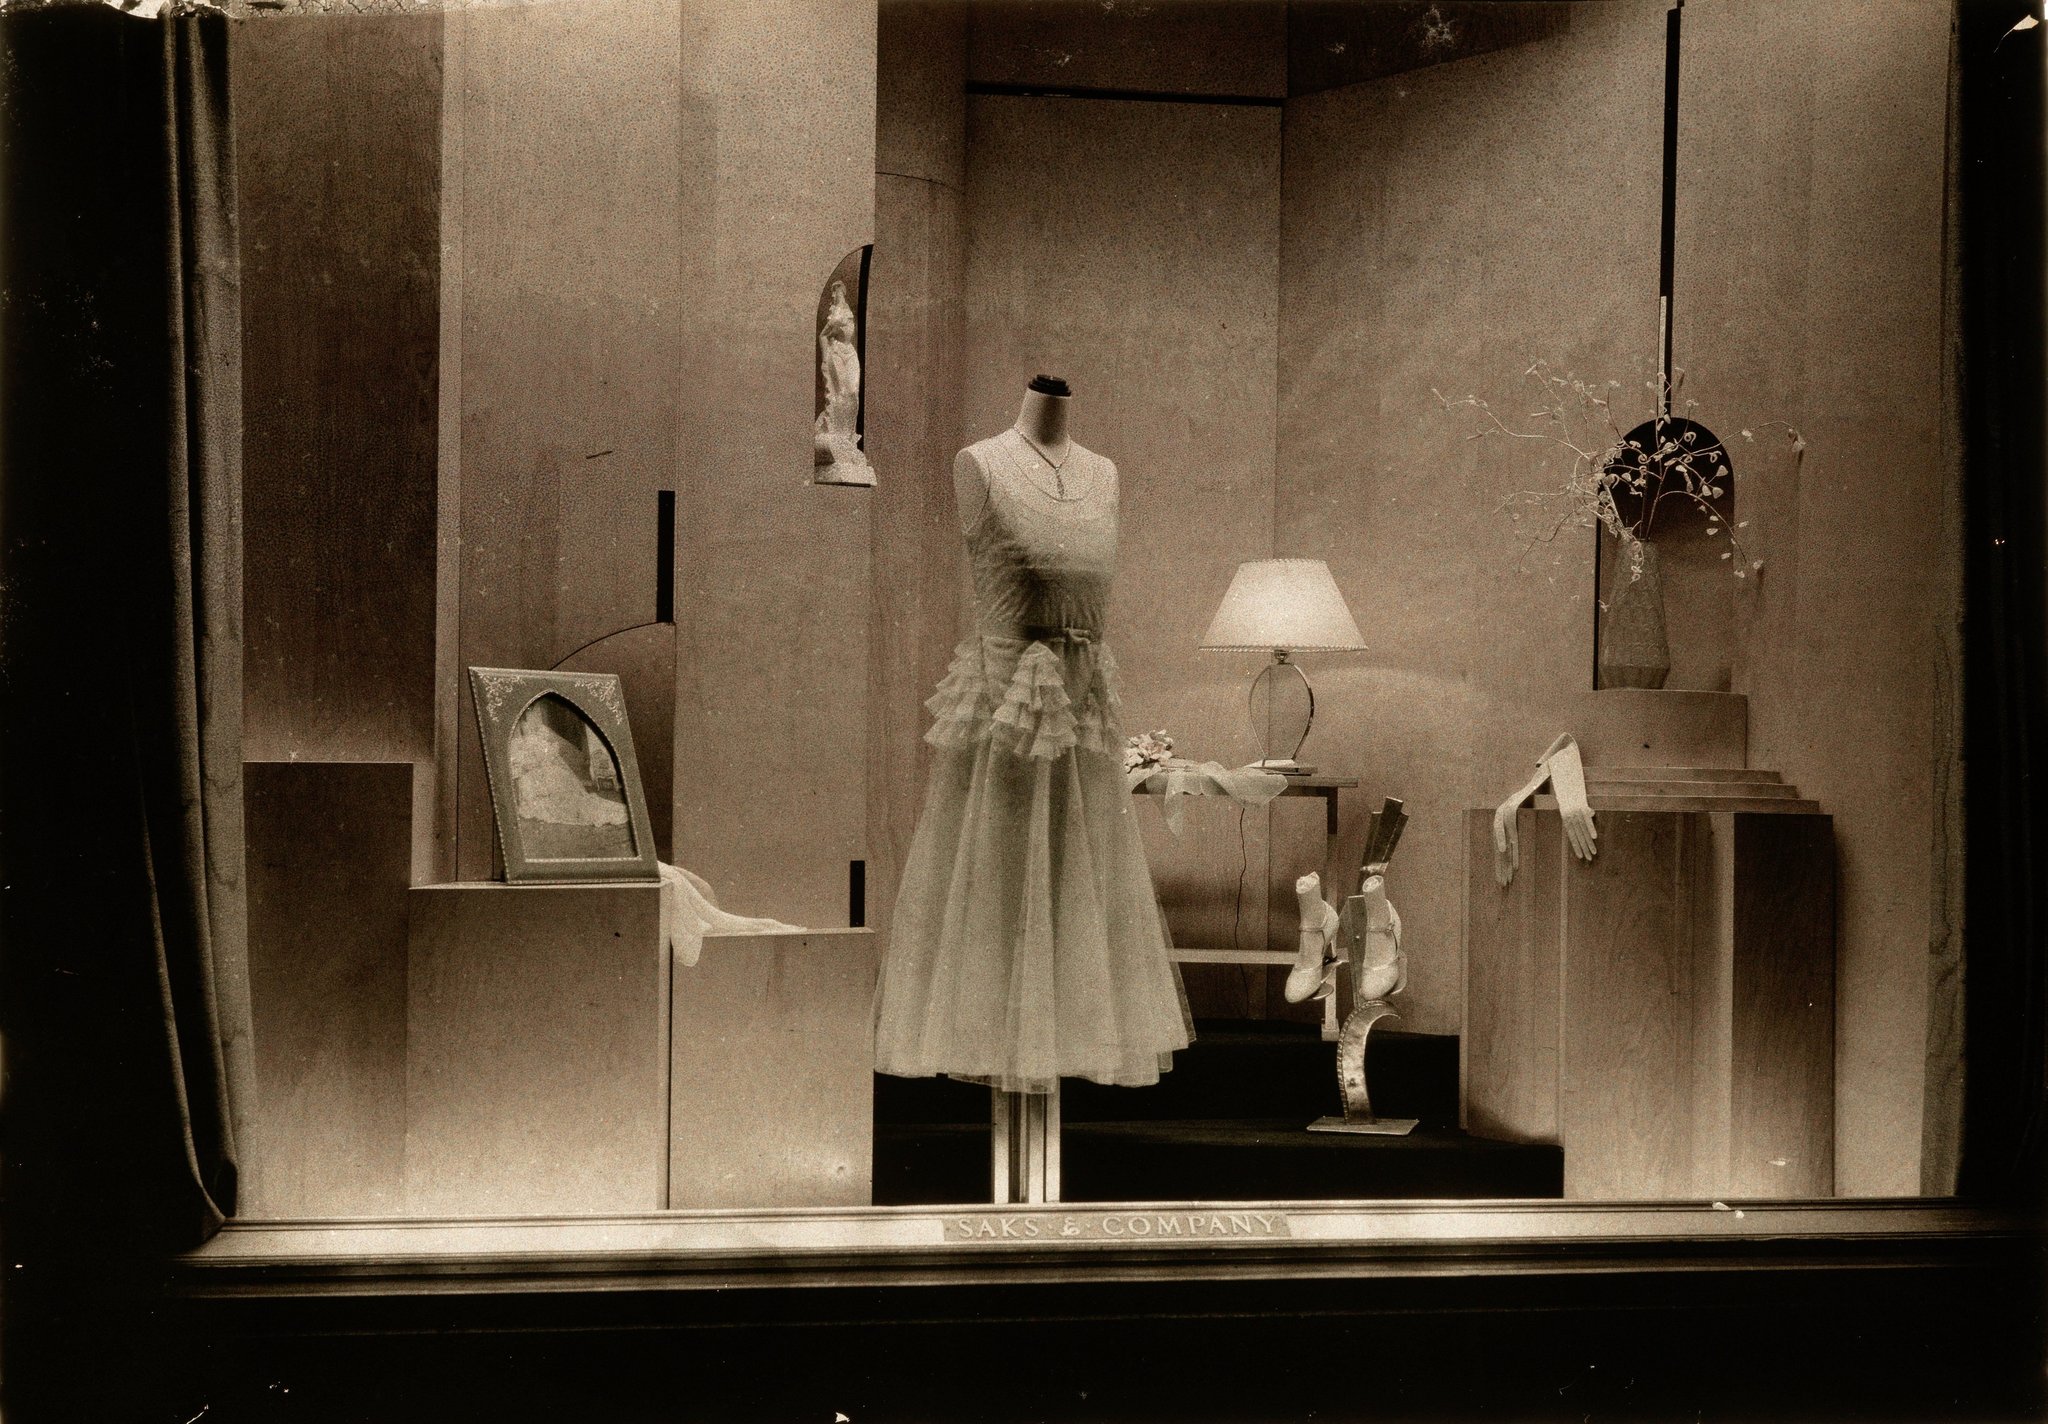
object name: photograph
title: Window at Saks, Fifth Avenue, New York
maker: clifton r. adams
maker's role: fotograaf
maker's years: 1890-1934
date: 1920-1935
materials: glass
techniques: autochrome process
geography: new york city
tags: shop-window, show-window, new york (city)